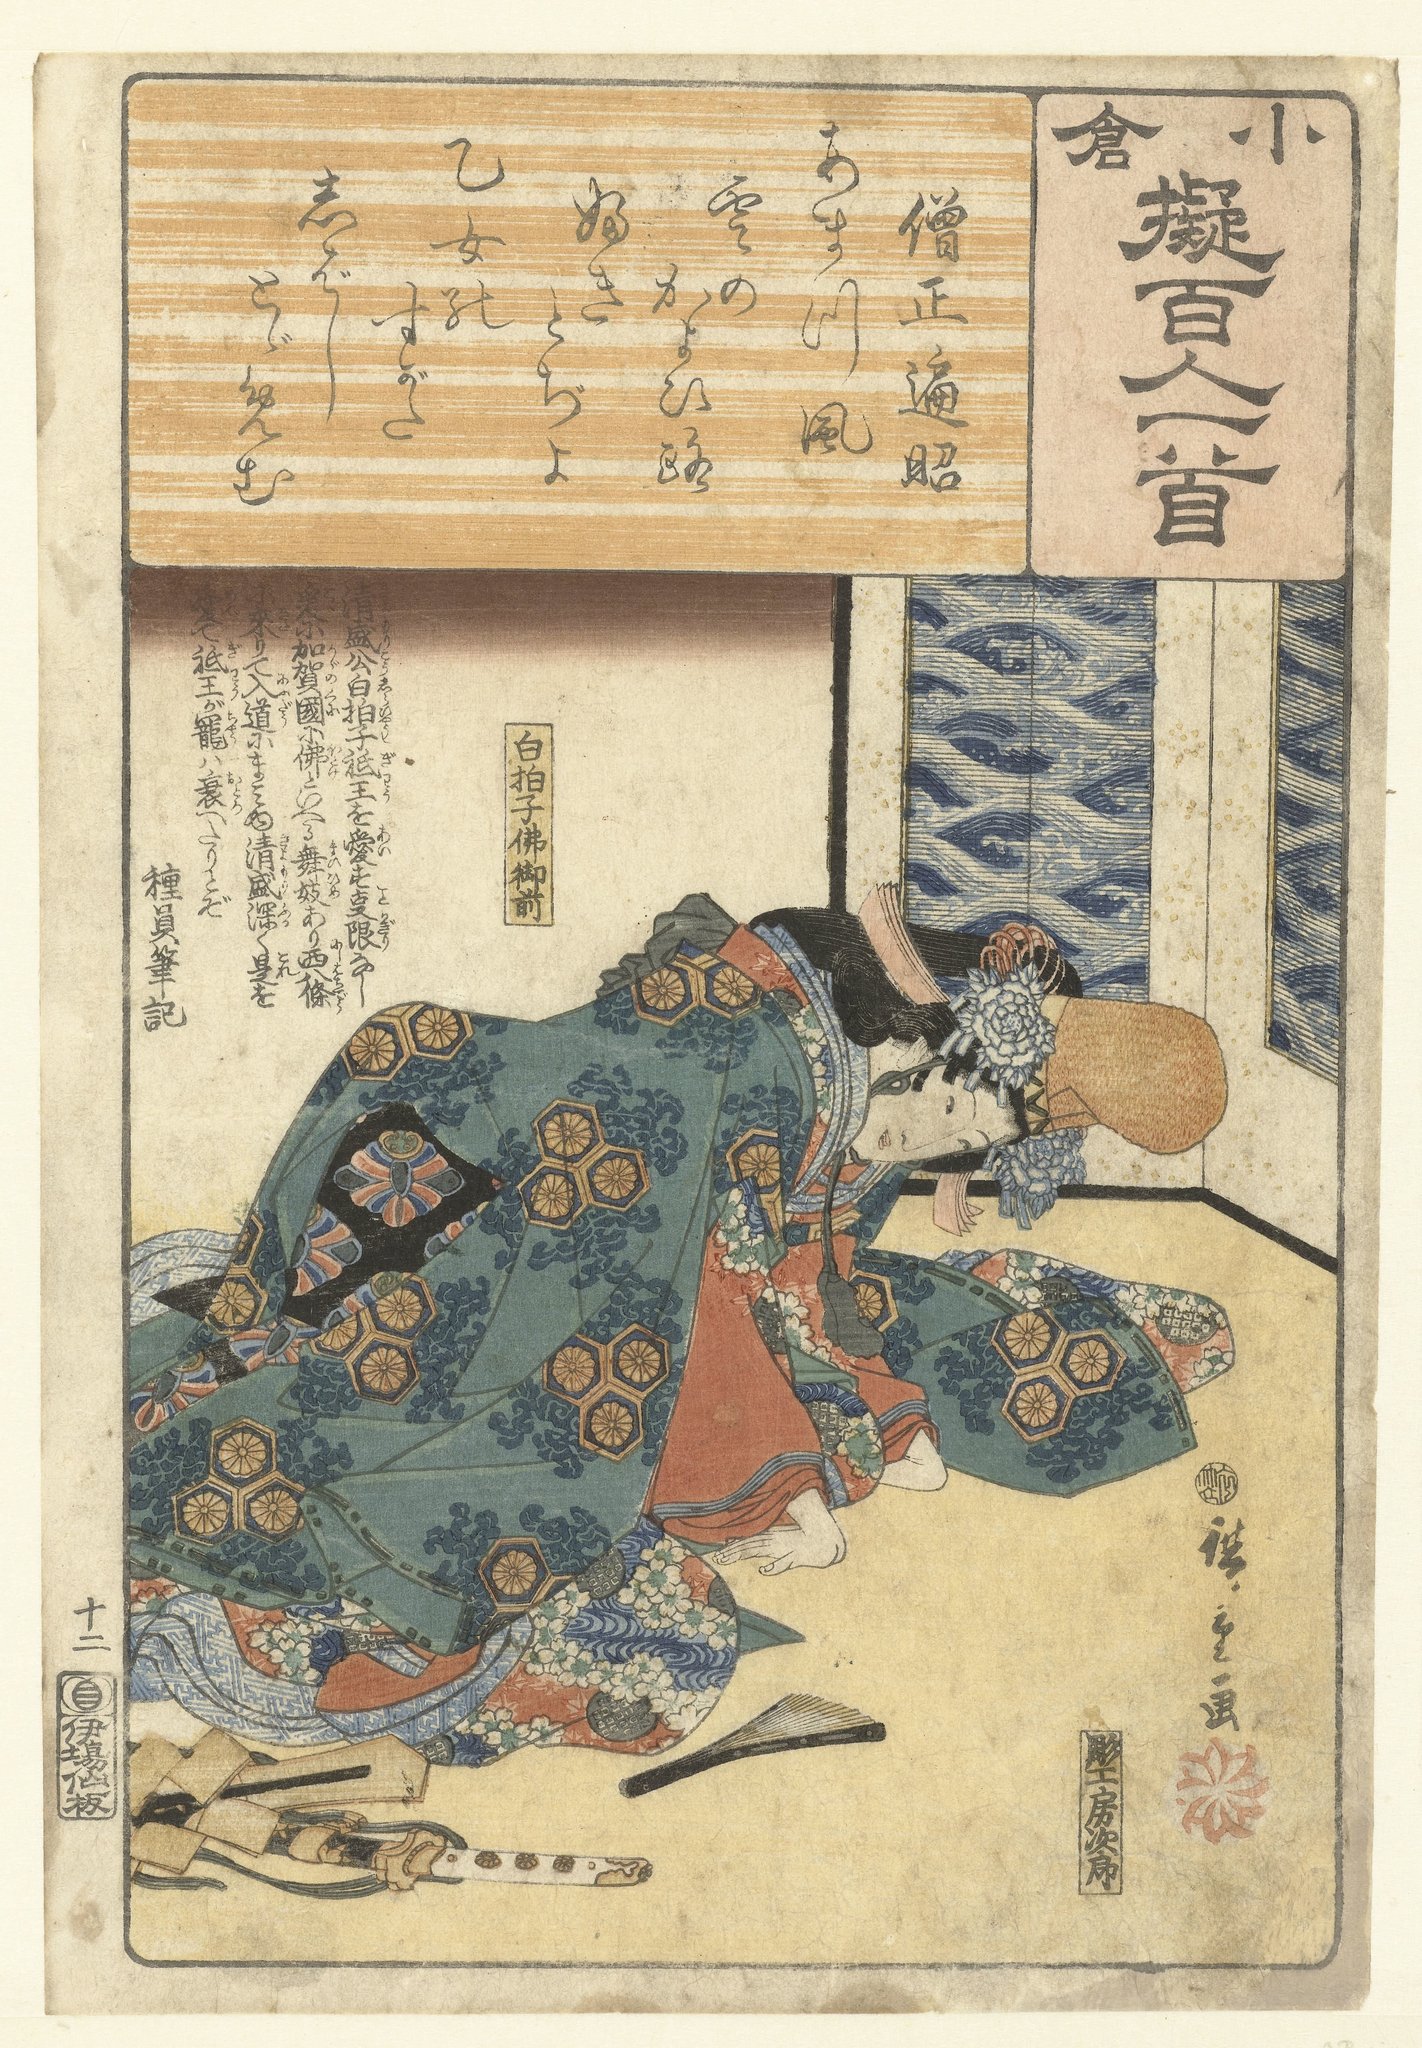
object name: print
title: Sojo Henjo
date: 1845-1846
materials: paper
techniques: woodcut, nishiki e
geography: japan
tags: adult woman, screen, folding screen, kneeling on both knees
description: De shirabyoshi danseres Hotoke Gozen, knielend voor kamerscherm, een waaier en zwaard naast haar op de vloer. Gedicht in oranje gestreept cartouche linksboven; eronder commentaar op de voorstelling.